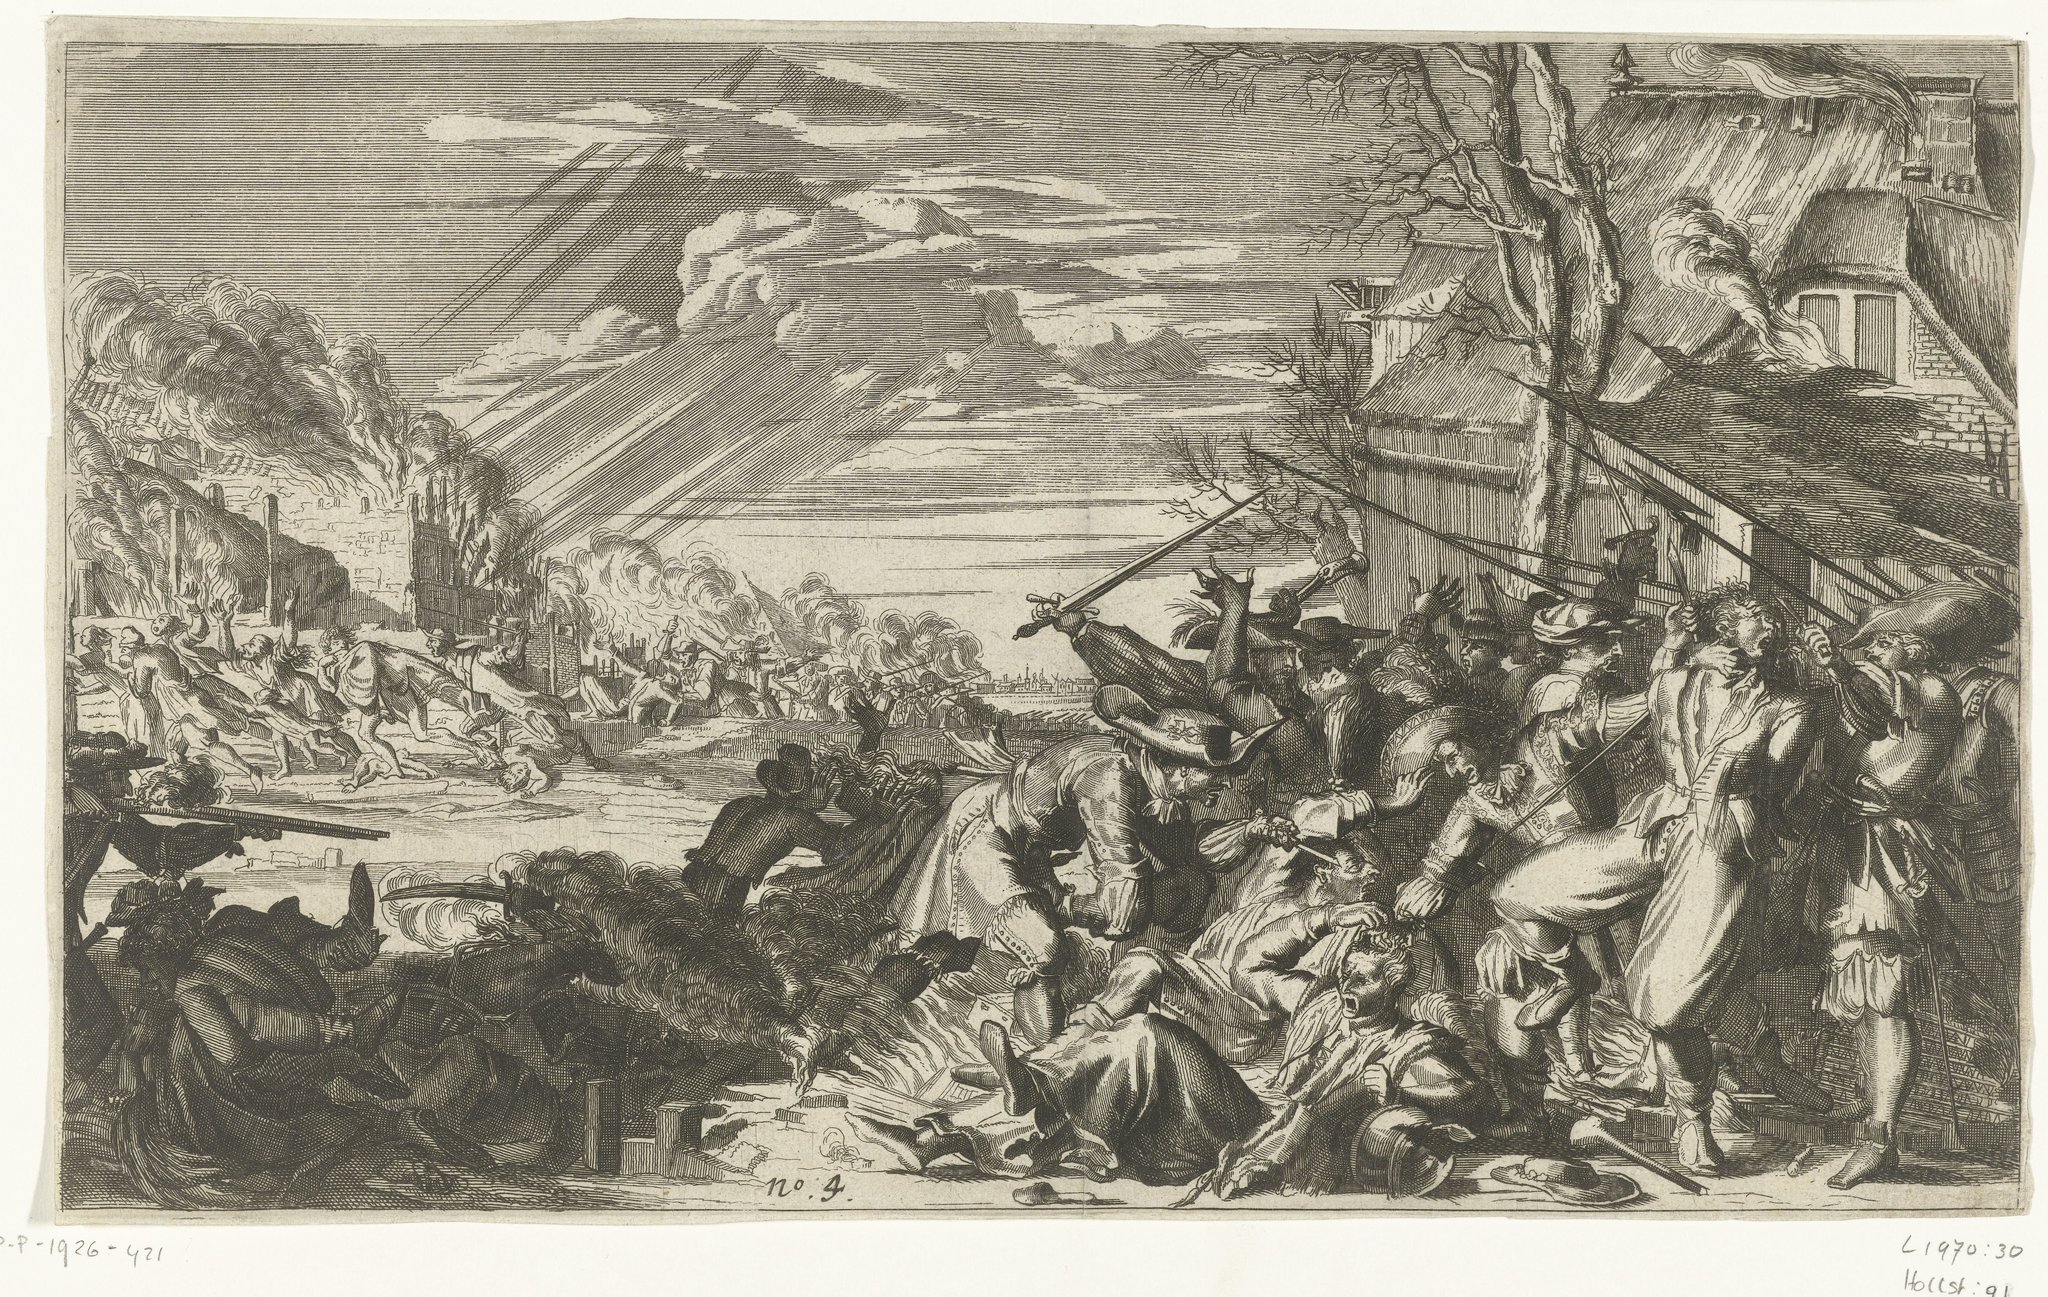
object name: book illustration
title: Wreedheden in een dorp, 1672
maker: Anonymous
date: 1673-1677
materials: paper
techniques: engraving, etching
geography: netherlands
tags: massacre ~ war, bodegraven, rampjaar (disaster year)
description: Prent ook gebruikt in: Bosch, Lambert van den. Toneel des oorlogs, opgerecht in de Vereenigde Nederlanden; door de wapenen van de koningen van Vrankrijk en Engeland, Keulsche en Munstersche (…). 4 delen. Amsterdam: Jacob van Meurs en Johannes van Someren, 1675, dl. 3, p. 122. En in: Valckenier, Peter en Andreas Muller. Das verwirrte Europa (…). 3 delen. Amsterdam: Hendrik en Dirk Boom, Joannes van Someren en Jacob van Meurs, 1677-1683, dl. 1 (1677), p. 444. Deze prent is gekopieerd naar een prent van Romeyn de Hooghe (RP-P-OB-77.196). Die prent is gebruikt in: Wicquefort, Abraham van. Avis fidelle aux veritables hollandois. Touchant ce qui s’est passé dans les villages de Bodegrave & Swammerdam, & les cruautés inoüies, que les françois y ont exercées (…). S.l. [Den Haag]: s.n.[Daniel en Johannes Steucker], 1673.